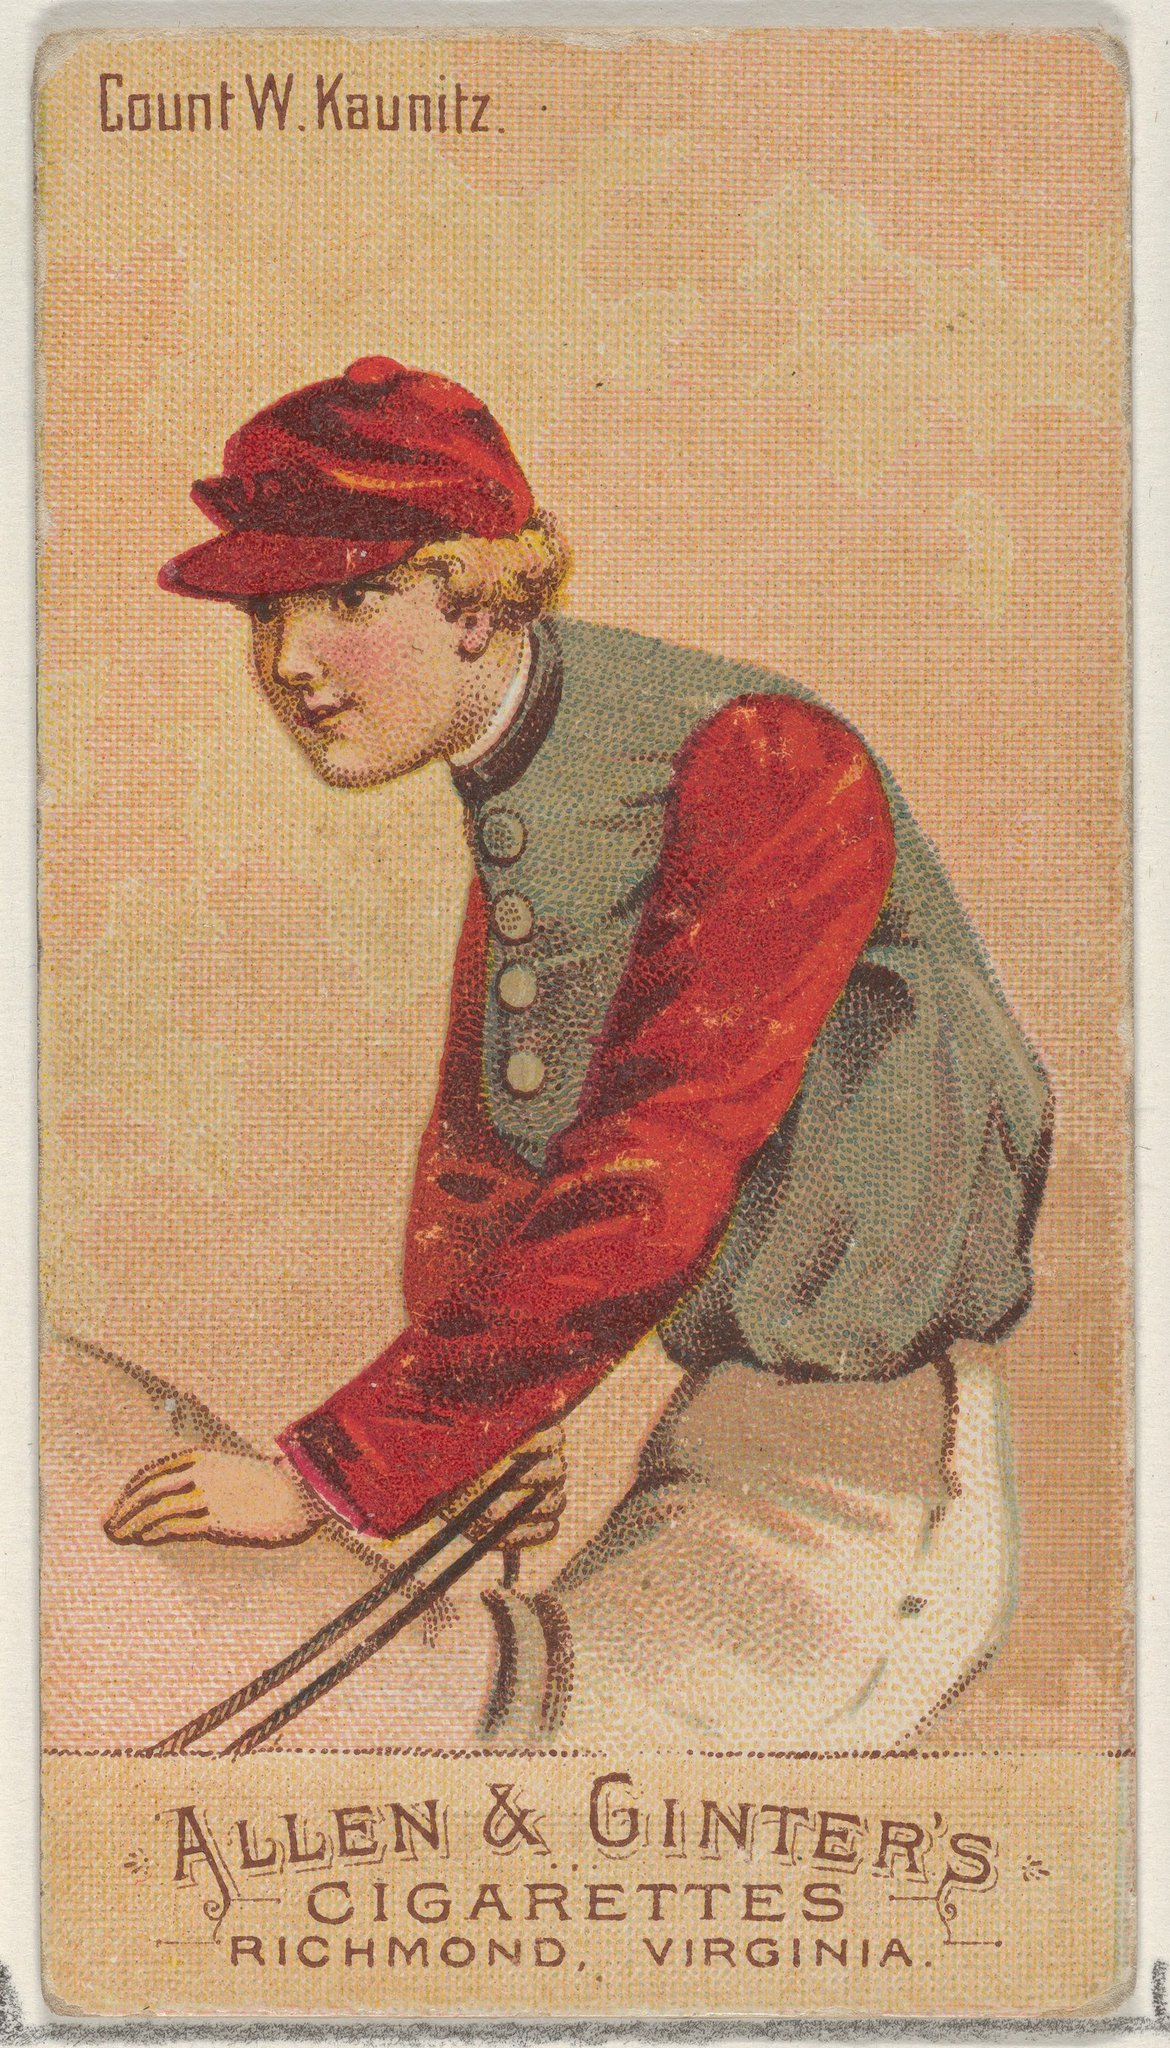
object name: print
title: Count W. Kaunitz, from the Racing Colors of the World series (N22b) for Allen & Ginter Cigarettes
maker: allen & ginter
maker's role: publisher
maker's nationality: american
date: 1888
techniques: color lithograph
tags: men,jockeys